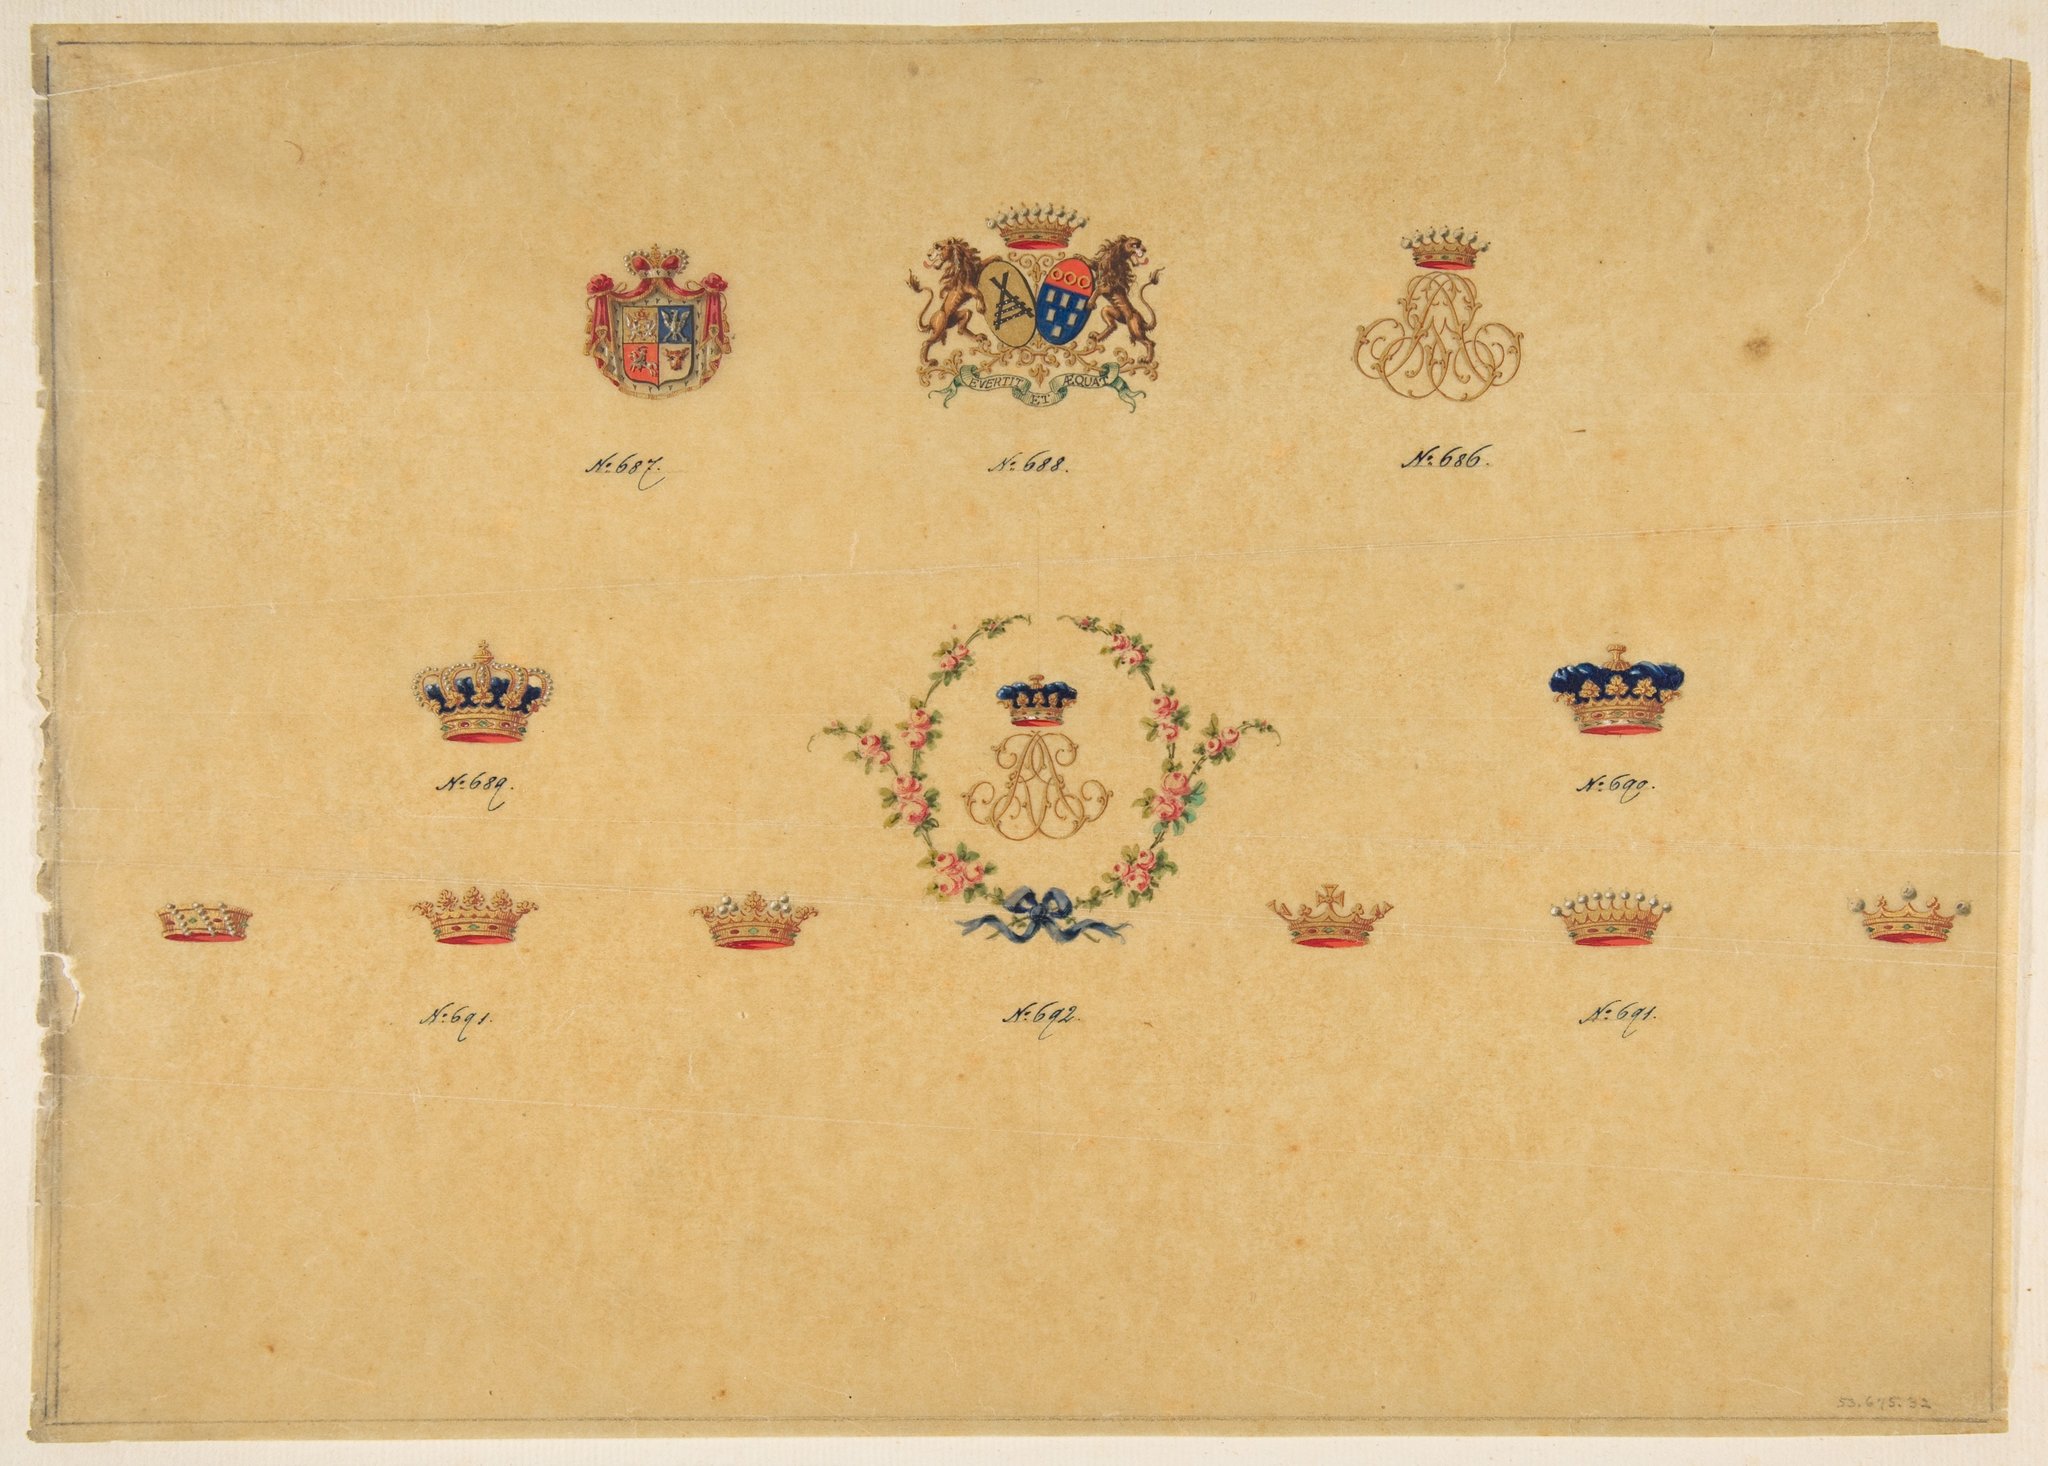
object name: drawing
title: Sheet of Monogram Designs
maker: anonymous, french, 19th century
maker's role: artist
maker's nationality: french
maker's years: 1800-1900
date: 1801-1900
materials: gilt, gold, gouache, ink, watercolor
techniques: pen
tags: coat of arms